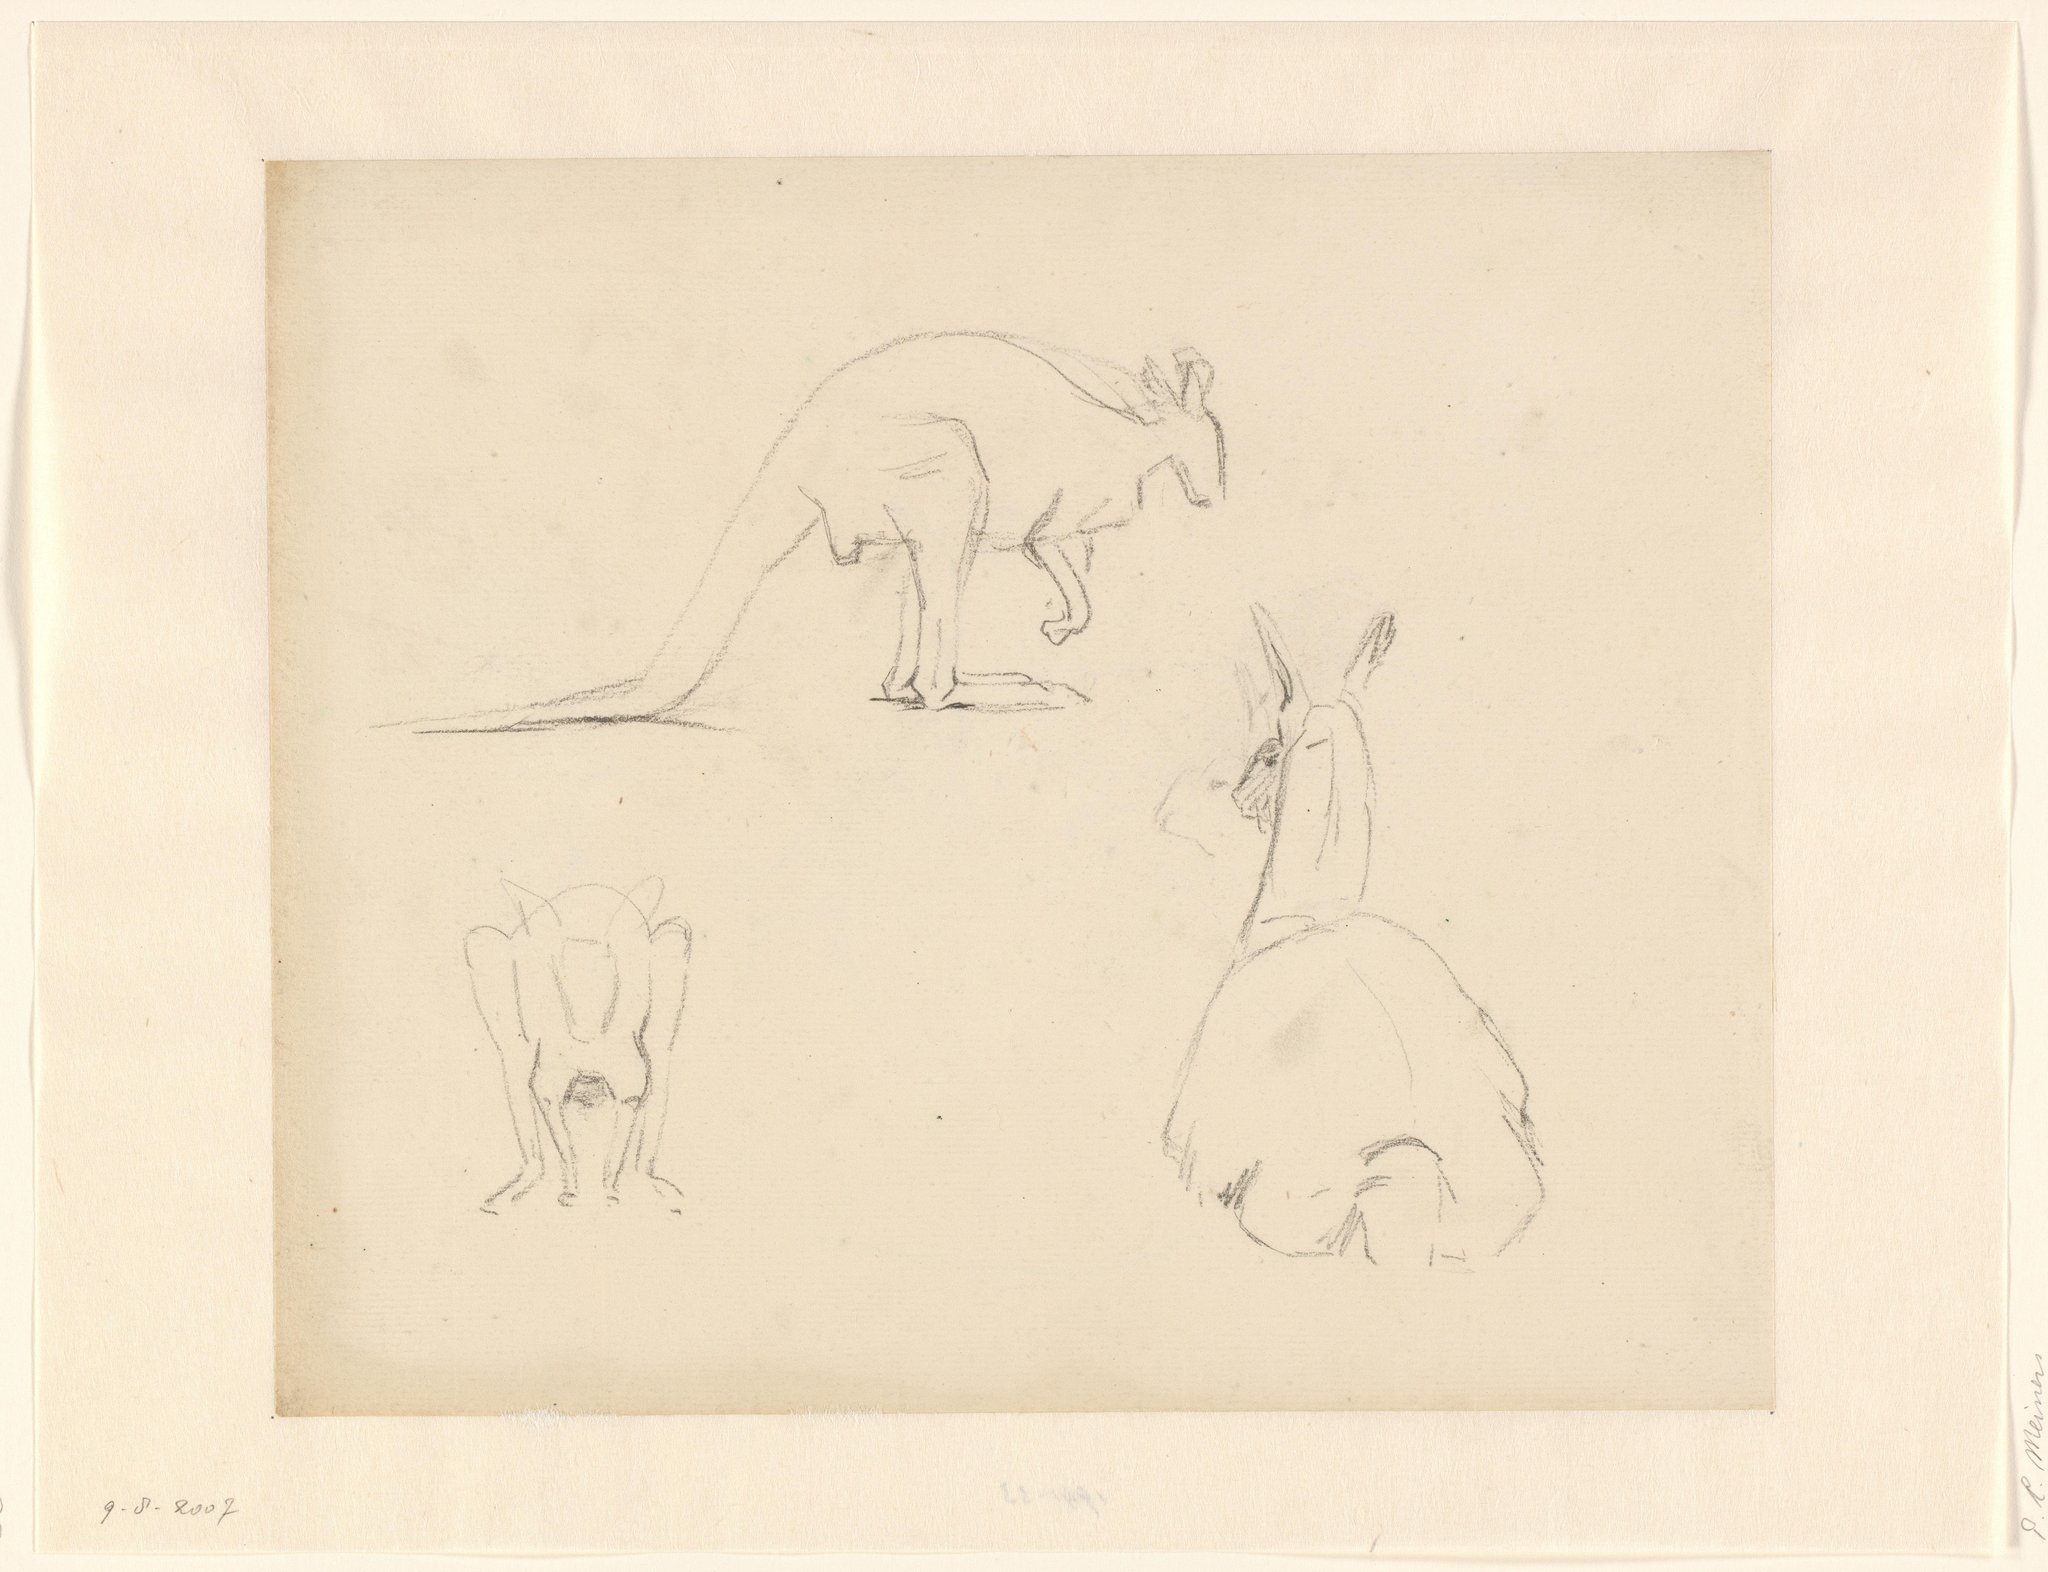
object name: drawing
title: Schetsen van kangoeroes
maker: piet meiners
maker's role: draughtsman, painter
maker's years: 1857-1903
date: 1867-1903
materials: chalk, paper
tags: other mammals (with name)